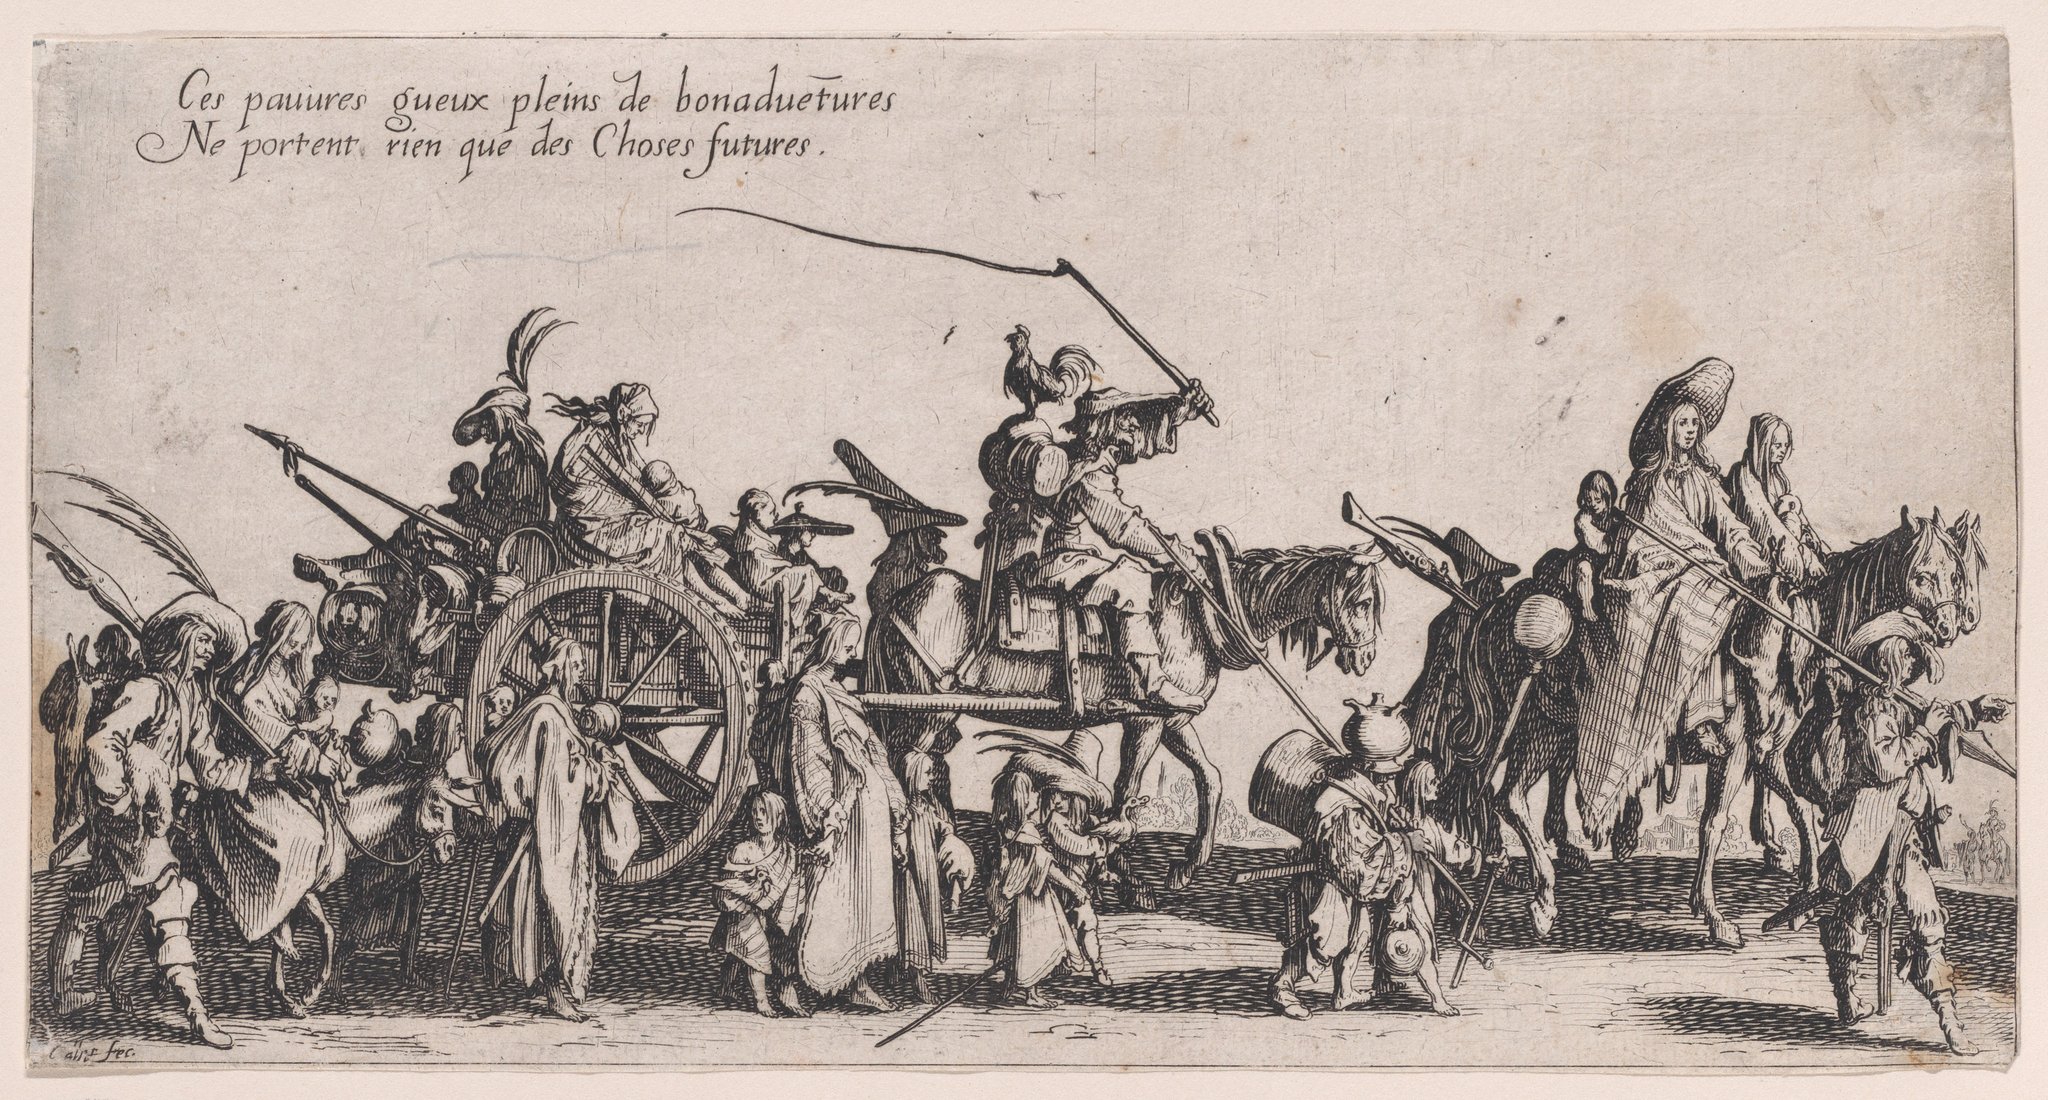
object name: print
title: Les Bohémiens en Marche: L'Arrière-Garde, pièce aussi appelée Le Départ (The Gypsies Travelling: The Rear Guard, also called The Departure), from "Le Bohémiens, série appelée aussi Les Égyptiens, La Marche des Bohémiens, La Vie Errante des Bohémiens, Les Marches Égyptiennes" (The Gypsies, series also called The Egyptiens, The Gypsy Troops, The Wandering Lives of Gypsies, The Egyptian Troops)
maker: jacques callot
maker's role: artist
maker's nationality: french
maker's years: 1592-1635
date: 1601-1633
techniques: engraving, etching